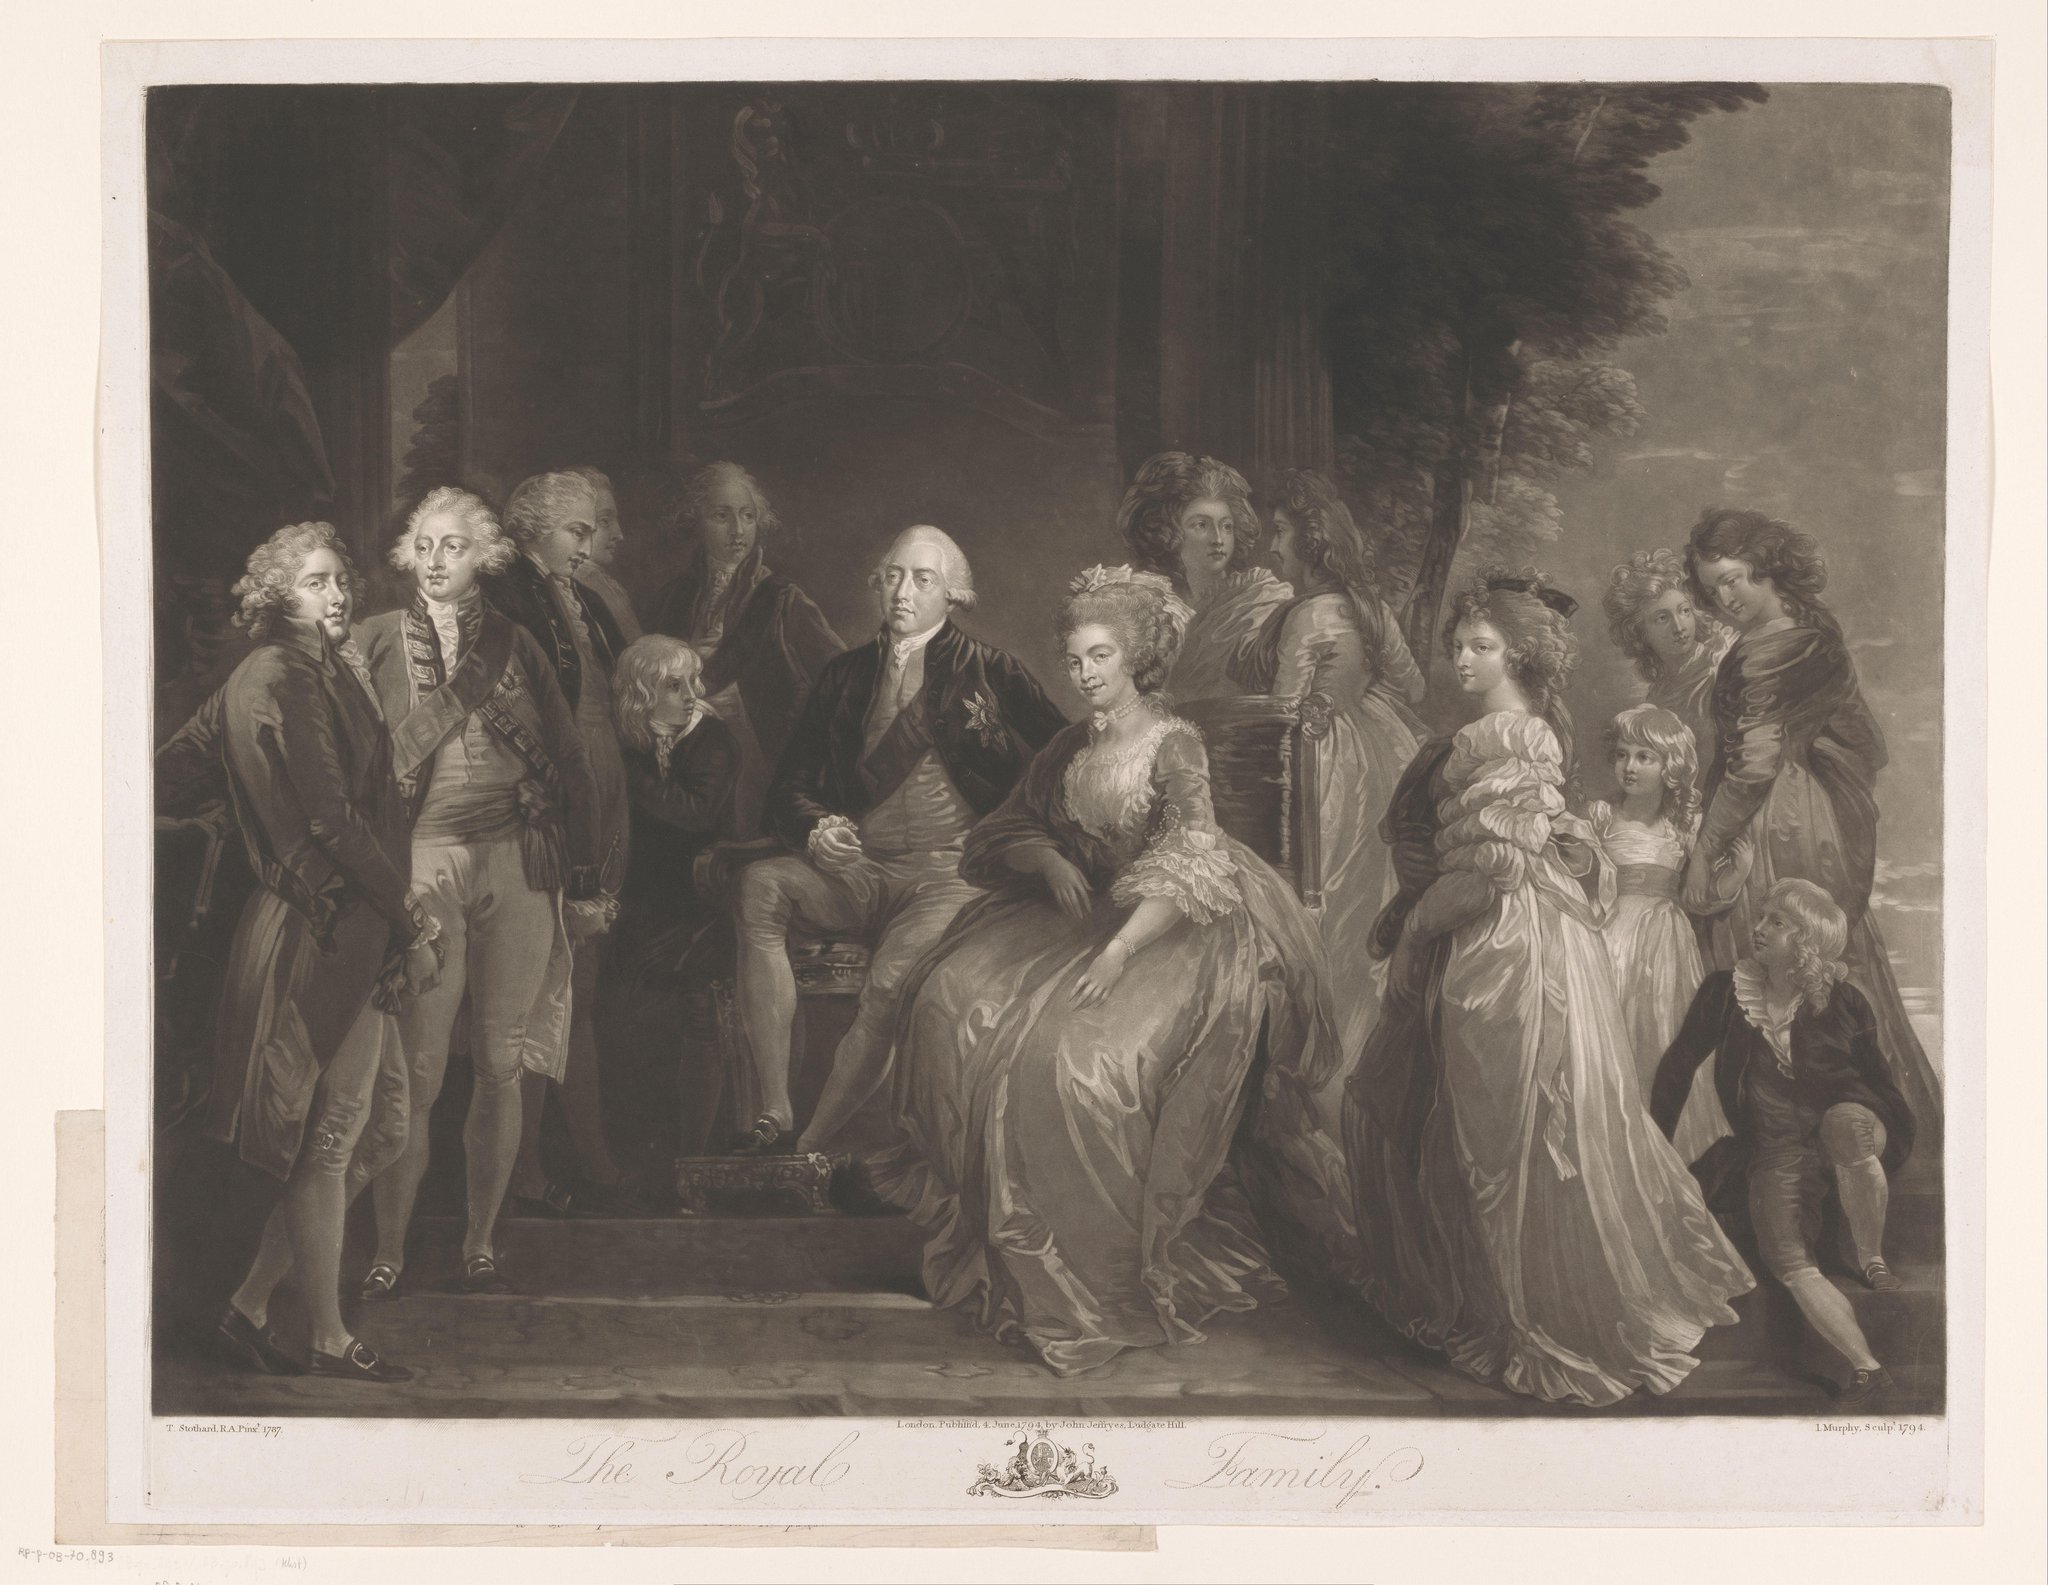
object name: print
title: Portret van de koninklijke familie van het Verenigd Koninkrijk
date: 1787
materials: paper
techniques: mezzotint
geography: london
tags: august frederik van sussex (hertog), politician, frederik (hertog van york en albany), united kingdom, charlotte van mecklenburg-strelitz (koningin van engeland en ierland), london, george iii (koning van het verenigd koninkrijk), george iv (koning van het verenigd koninkrijk), willem iv hendrik (koning van het verenigd koninkrijk en hannover), family of a ruler, and court, historical persons, family group, especially parents with their child(6) (6)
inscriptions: collector's mark: Lugt 2228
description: Toelichting over de personen op een prent in de collectie van het Rijksmuseum Amsterdam, inv. nr.: RP-P-OB-70.893.